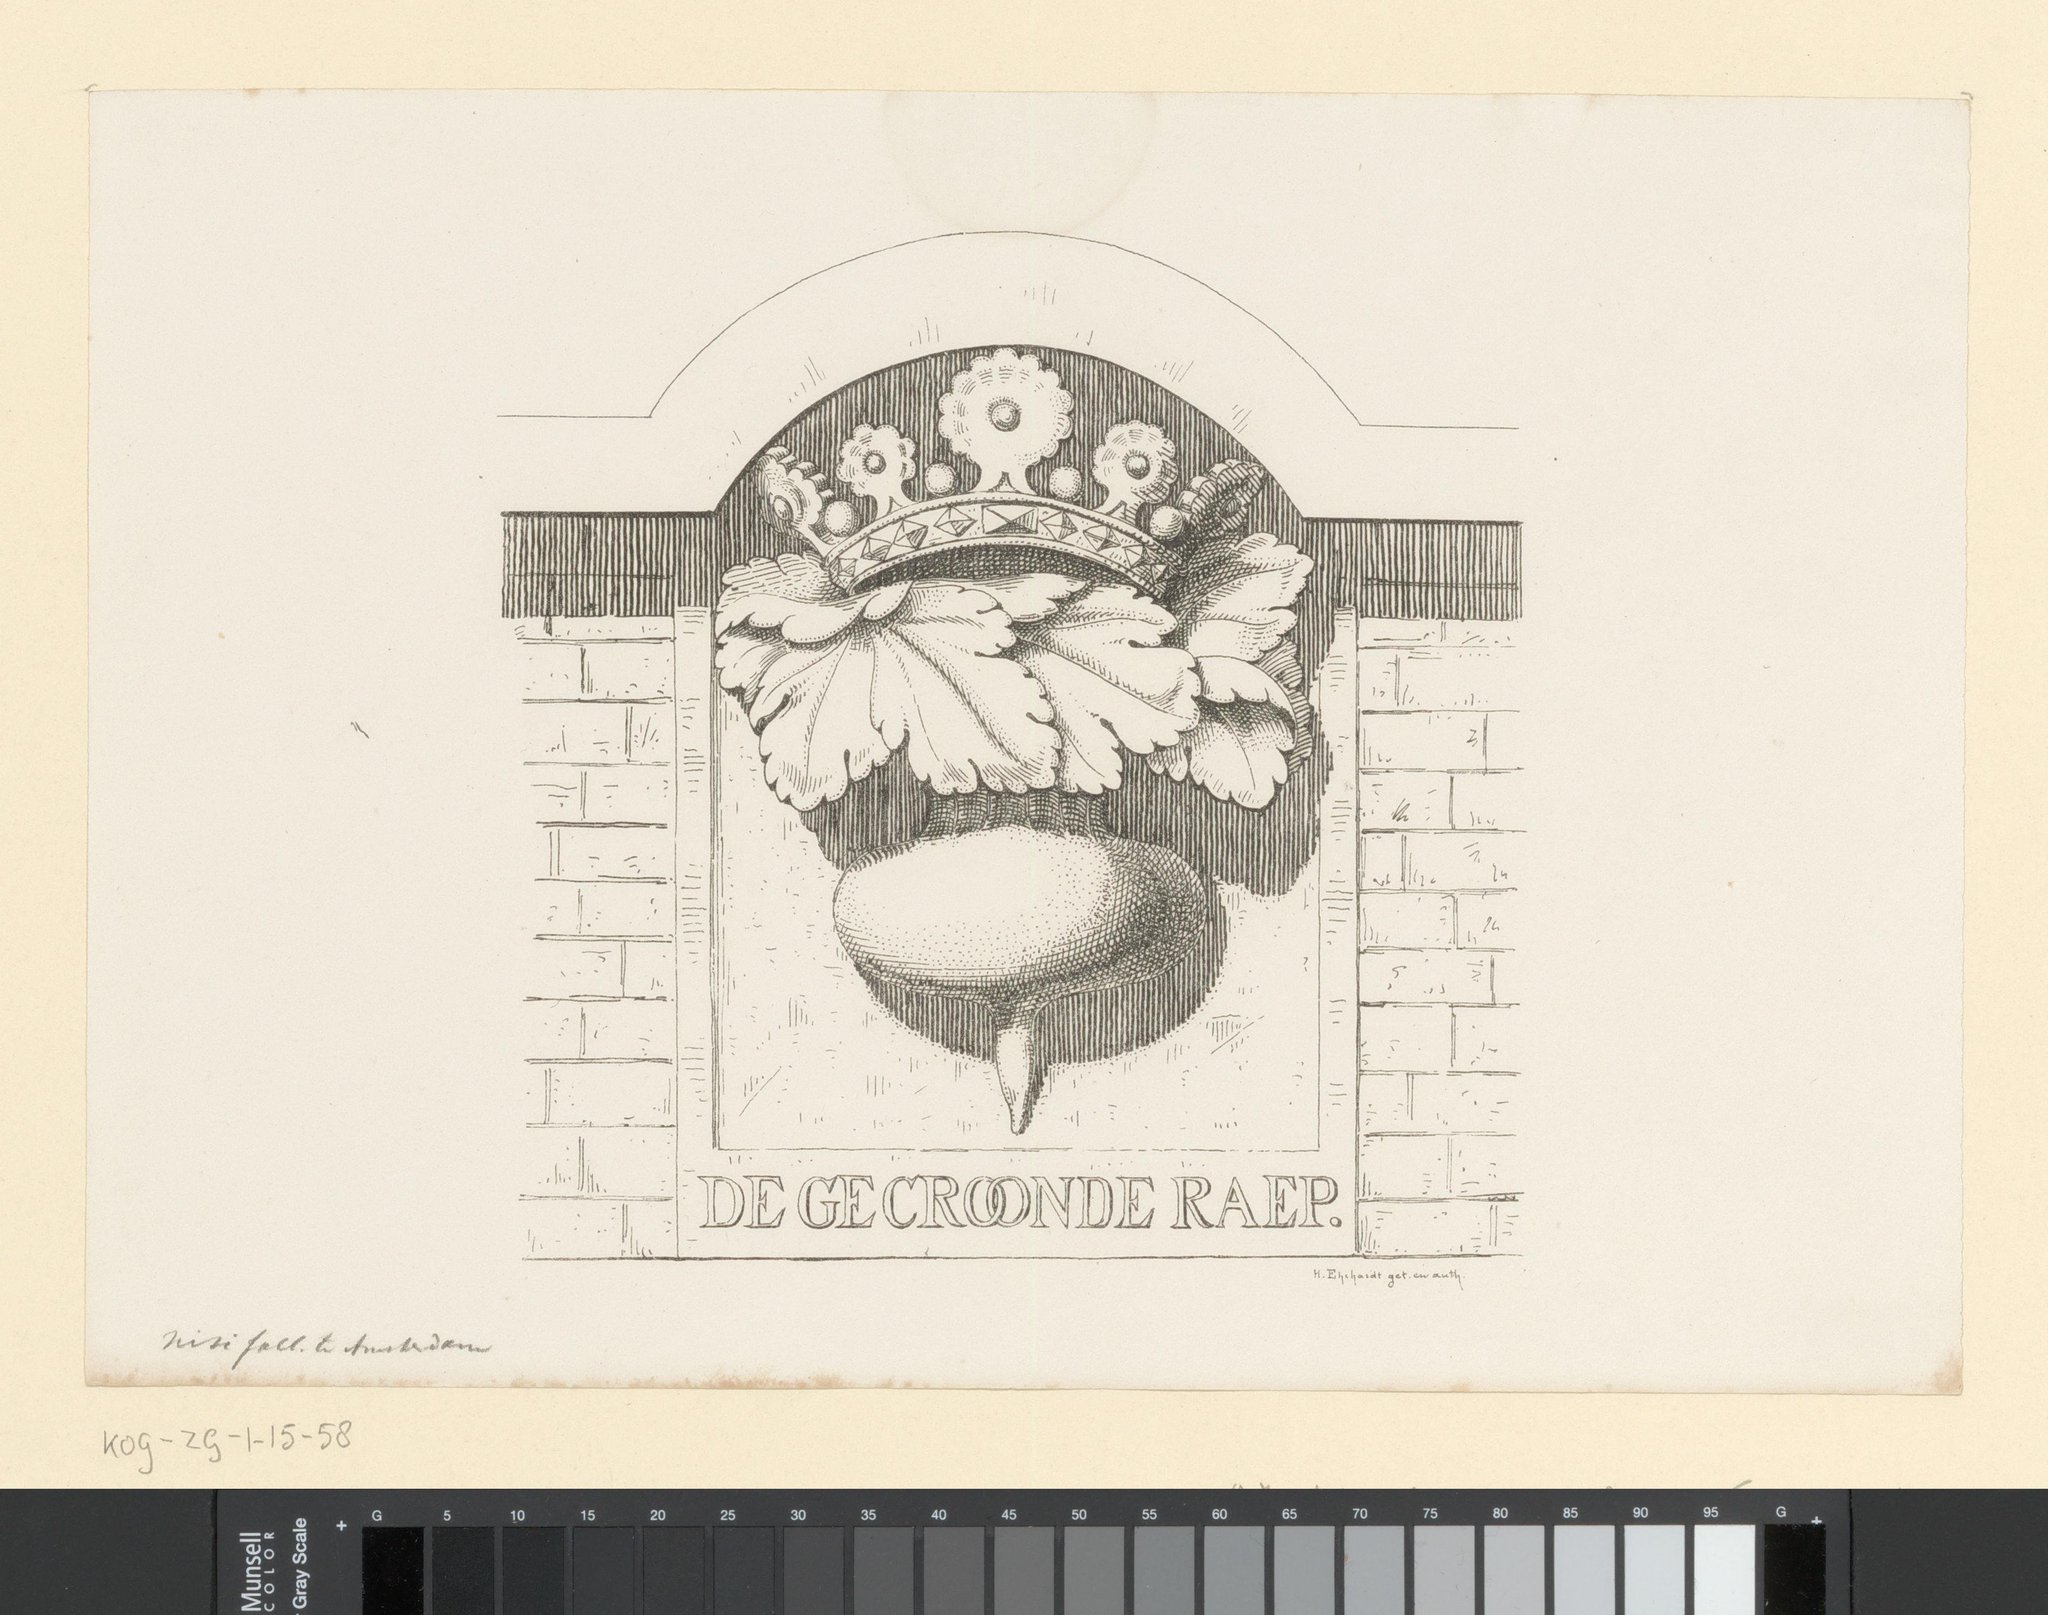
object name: print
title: Gevelsteen van De Gecroonde Raep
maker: h. ehrhardt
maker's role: draughtsman, print maker, publisher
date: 1800-1899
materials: paper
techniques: lithograph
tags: ornament ~ cartouche, (non-fruit) products of plants or trees: turnip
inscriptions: stamp, collector's mark: Lugt 1641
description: Onderwerpsrubrieken binnen de Atlas Zeden en Gewoonten: Handel, nijverheid en verkeer, Uithangteekens, gevelstenen.